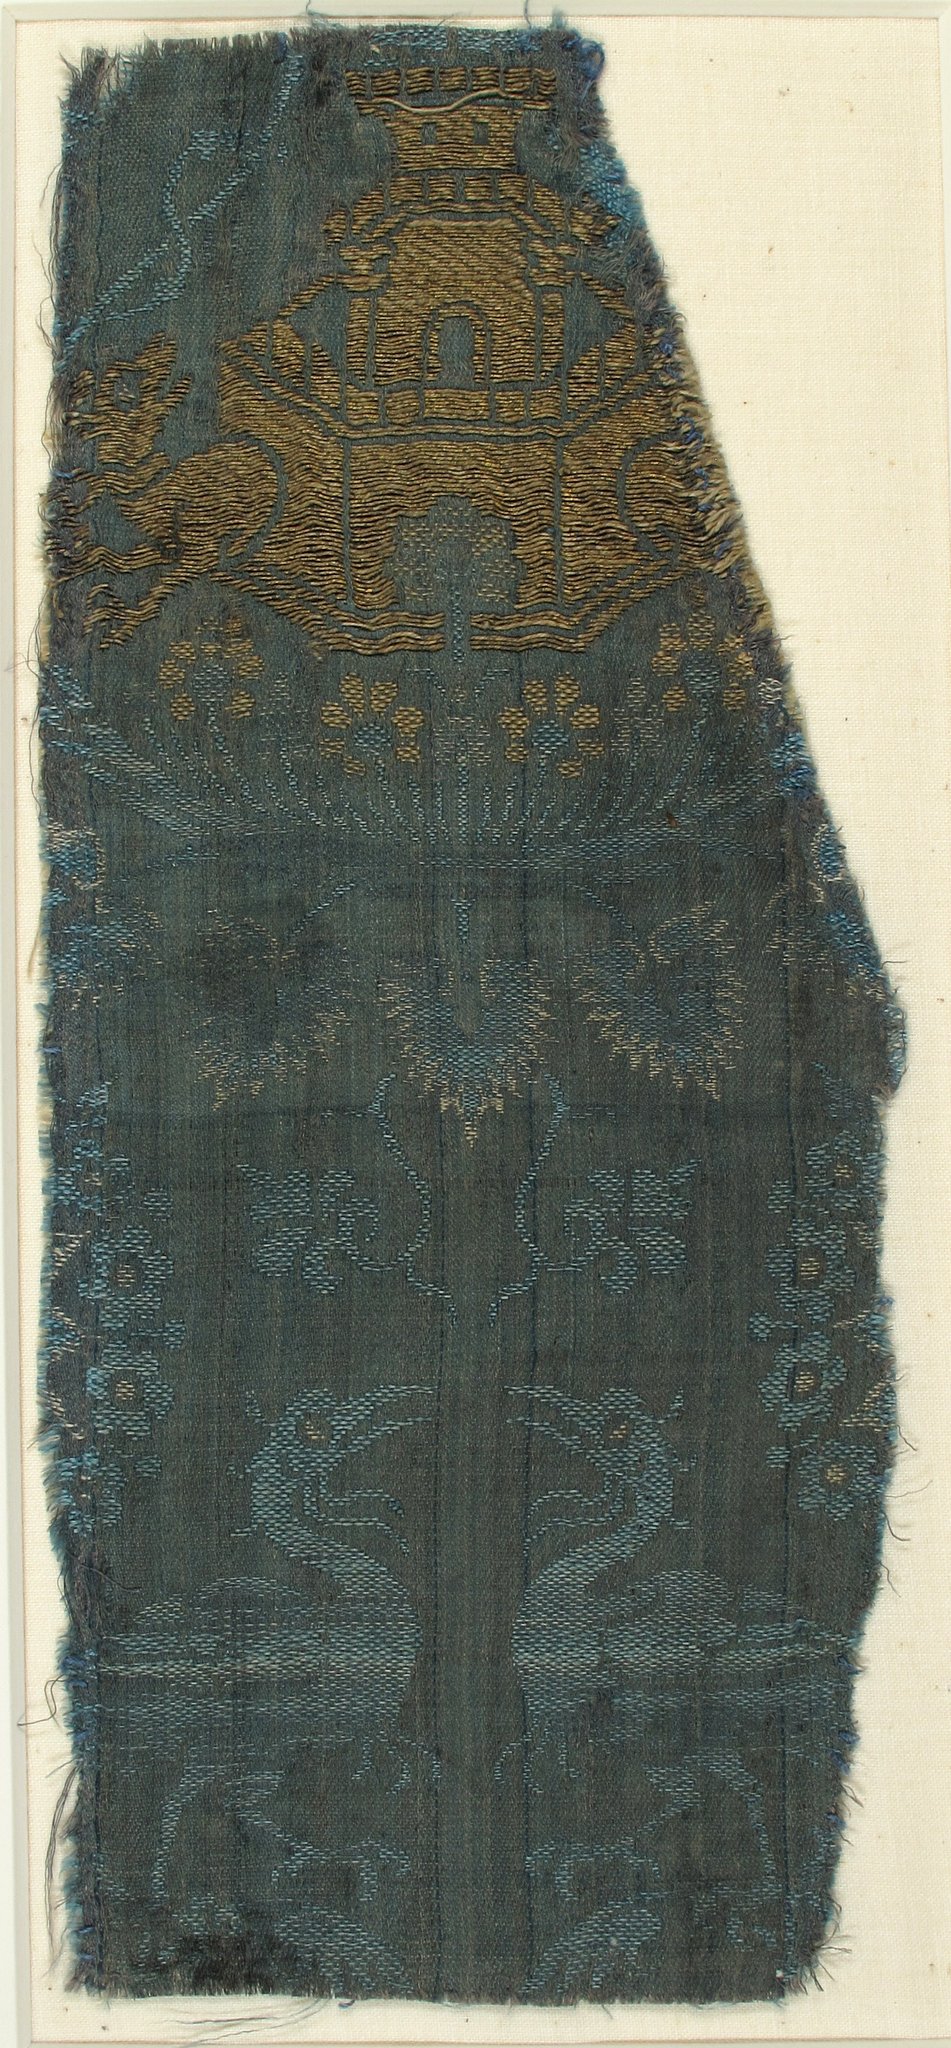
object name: textile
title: Brocade Textile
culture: italian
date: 1301-1400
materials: gold thread, silk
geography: italy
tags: birds